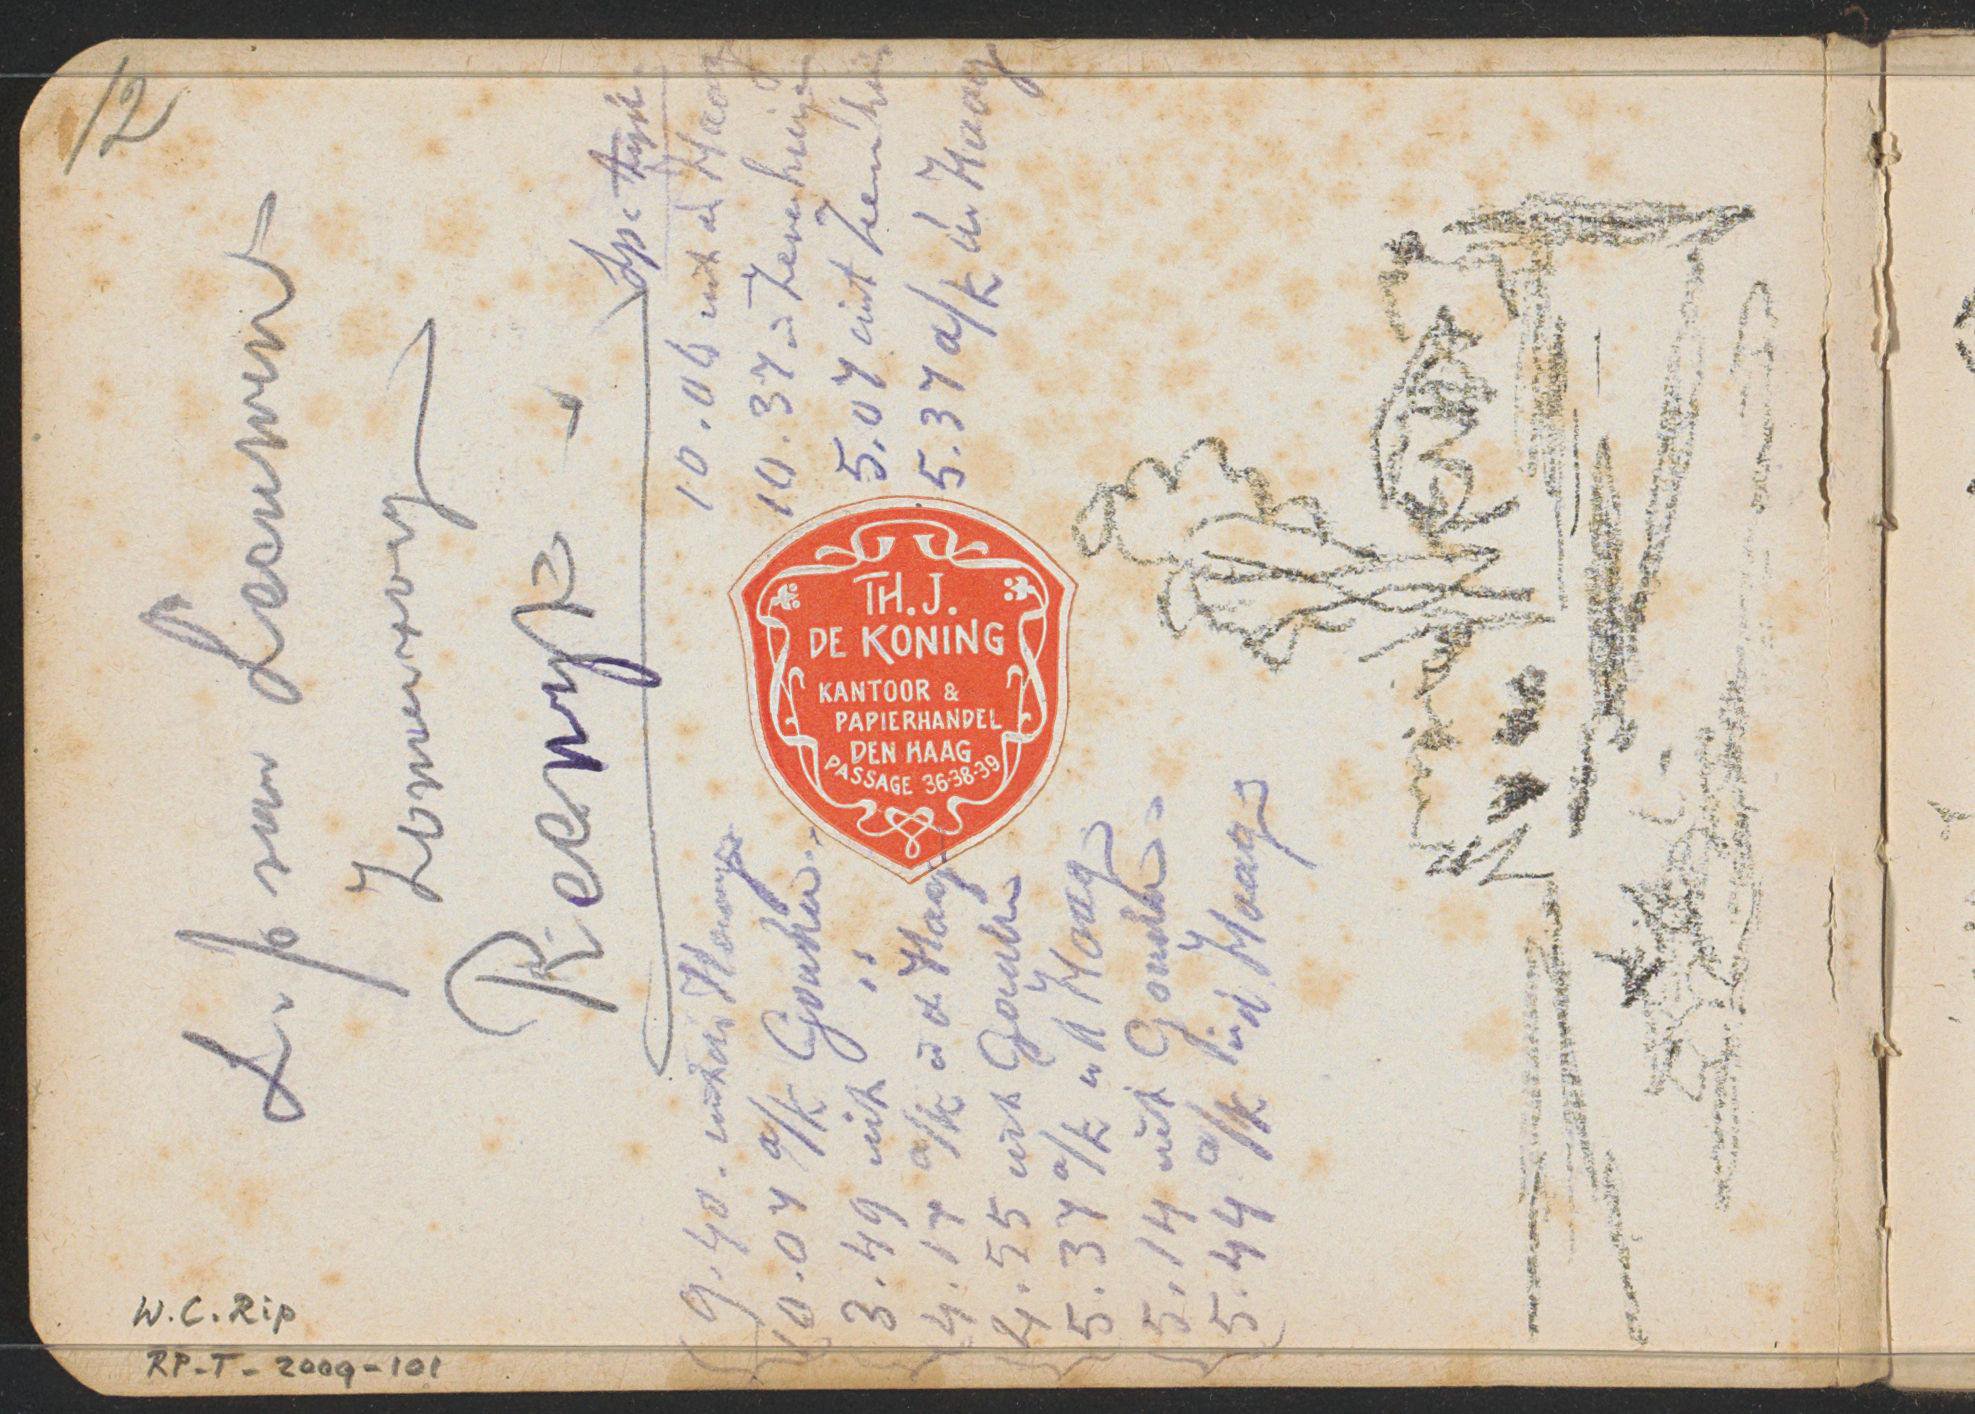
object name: sketchbook leaf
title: Landschap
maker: willem cornelis rip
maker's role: draughtsman, painter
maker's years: 1856-1922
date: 1866-1922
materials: chalk, paper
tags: landscapes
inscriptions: address: ‘L.p van Leeuwen/ Zomerweg/ Reewijk’, annotation: ‘9.40 - uit den Haag/ 10.04 a/k Gouda./ 3.49 uit Gouda/ 4.17 a/k d Haag/ [...]’, retailer's mark: ‘TH.J./ DE KONING/ Kantoor &/ Papierhandel/ DEN HAAG/ PASSAGE 36-38-39’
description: Voorste schutblad uit een schetsboek met 44 bladen.